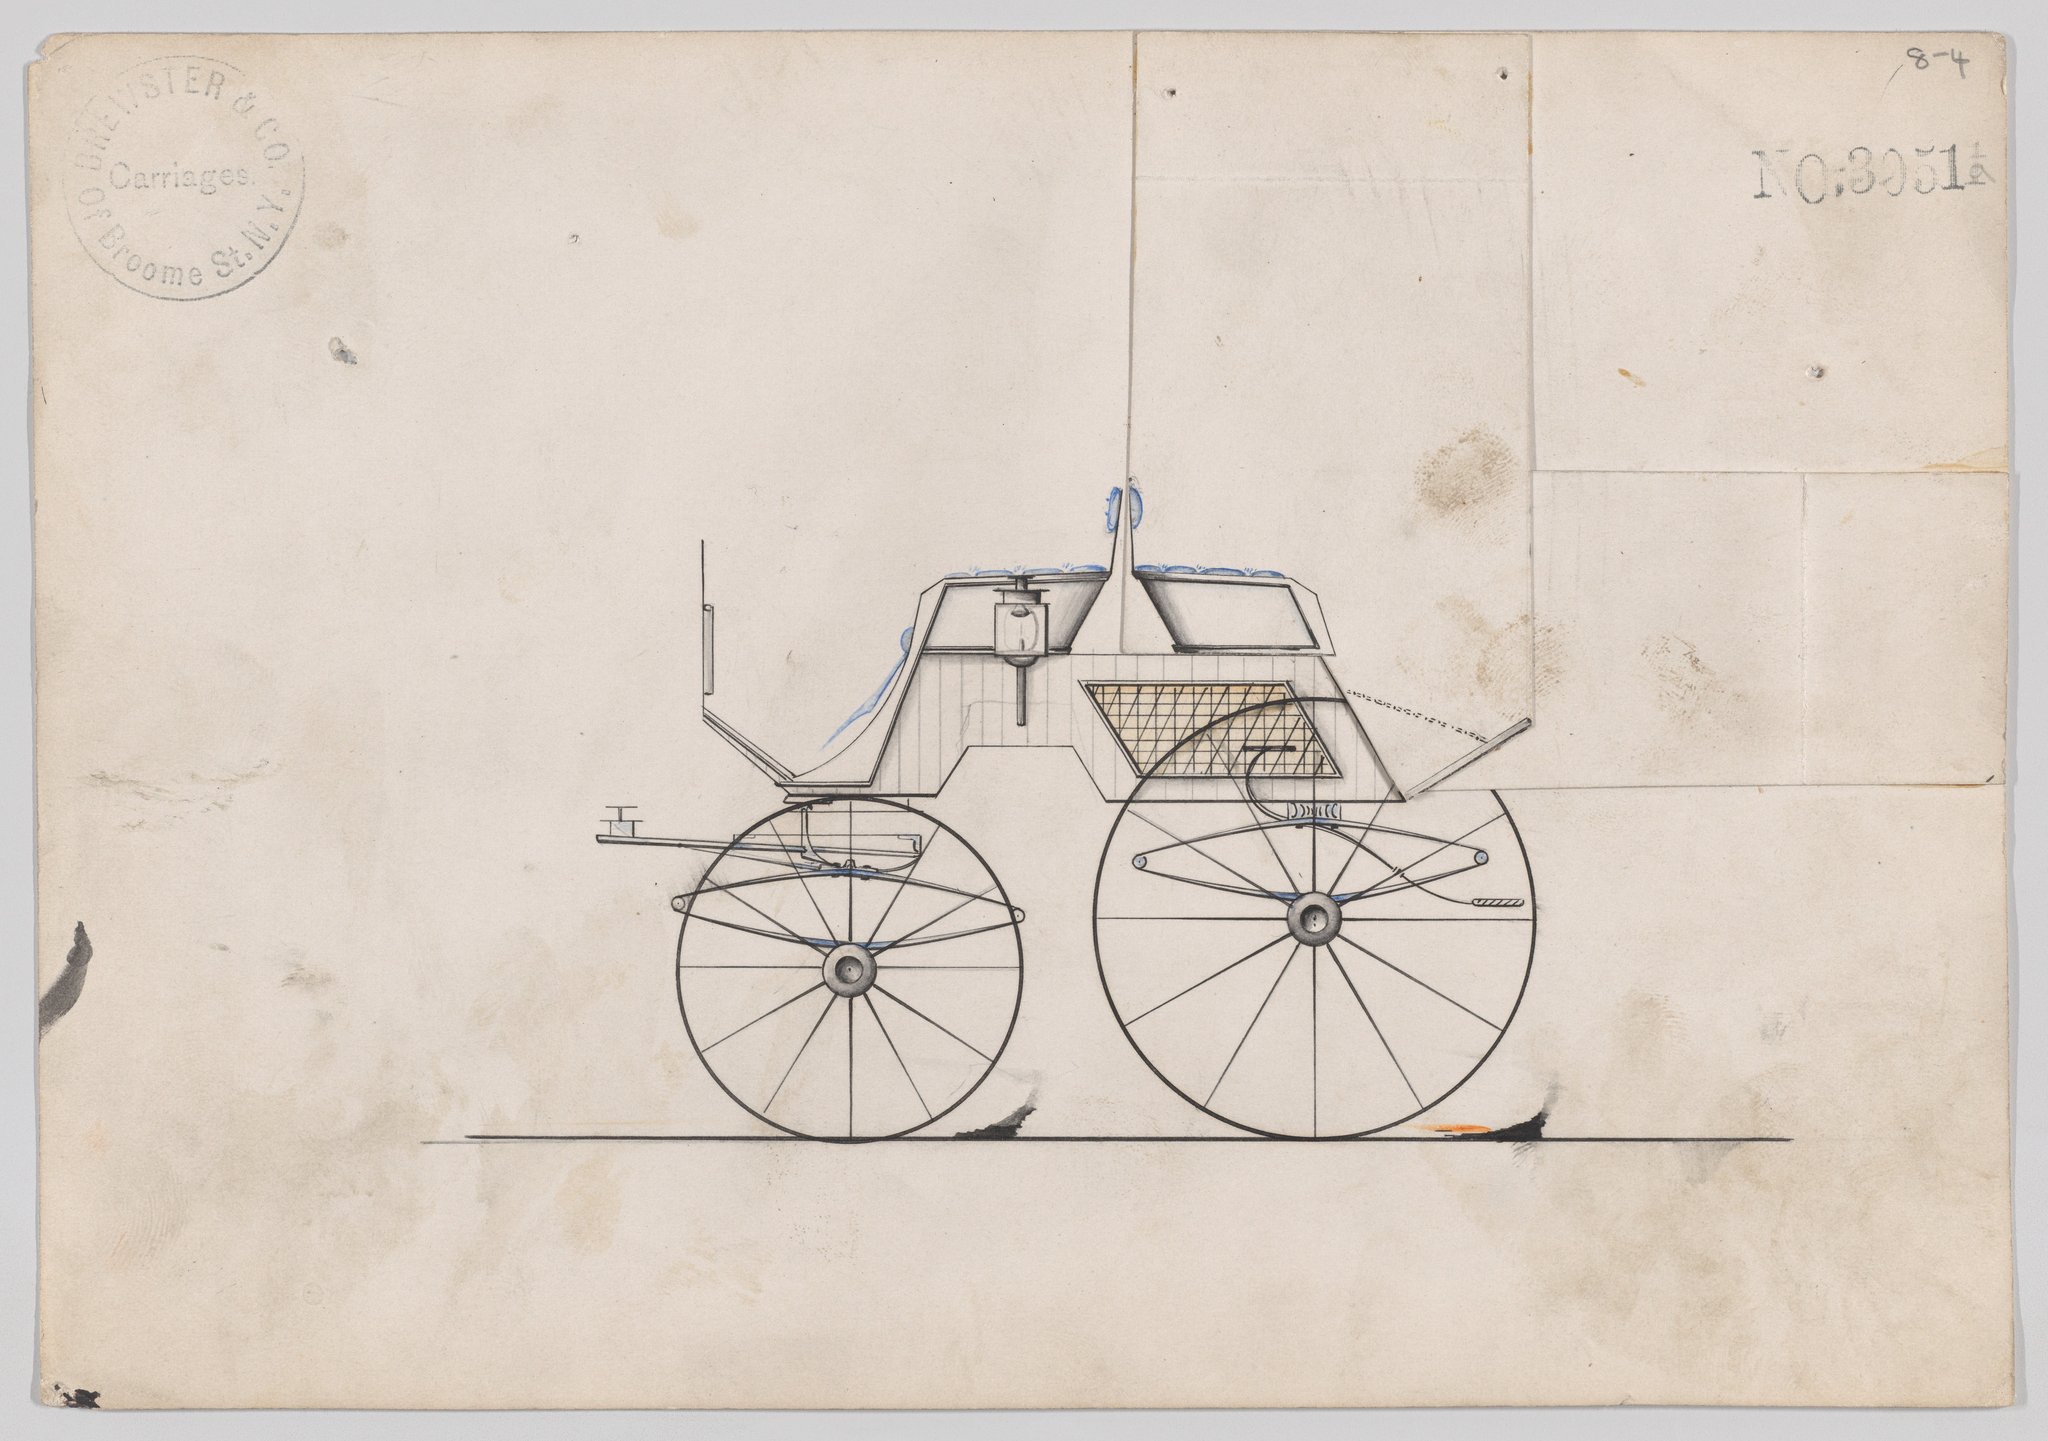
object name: drawing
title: Design for 4 seat Phaeton, no top, no. 3051a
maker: brewster & co.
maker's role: manufacturer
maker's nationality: american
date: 1874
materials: gouache, ink, watercolor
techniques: pen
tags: carriages